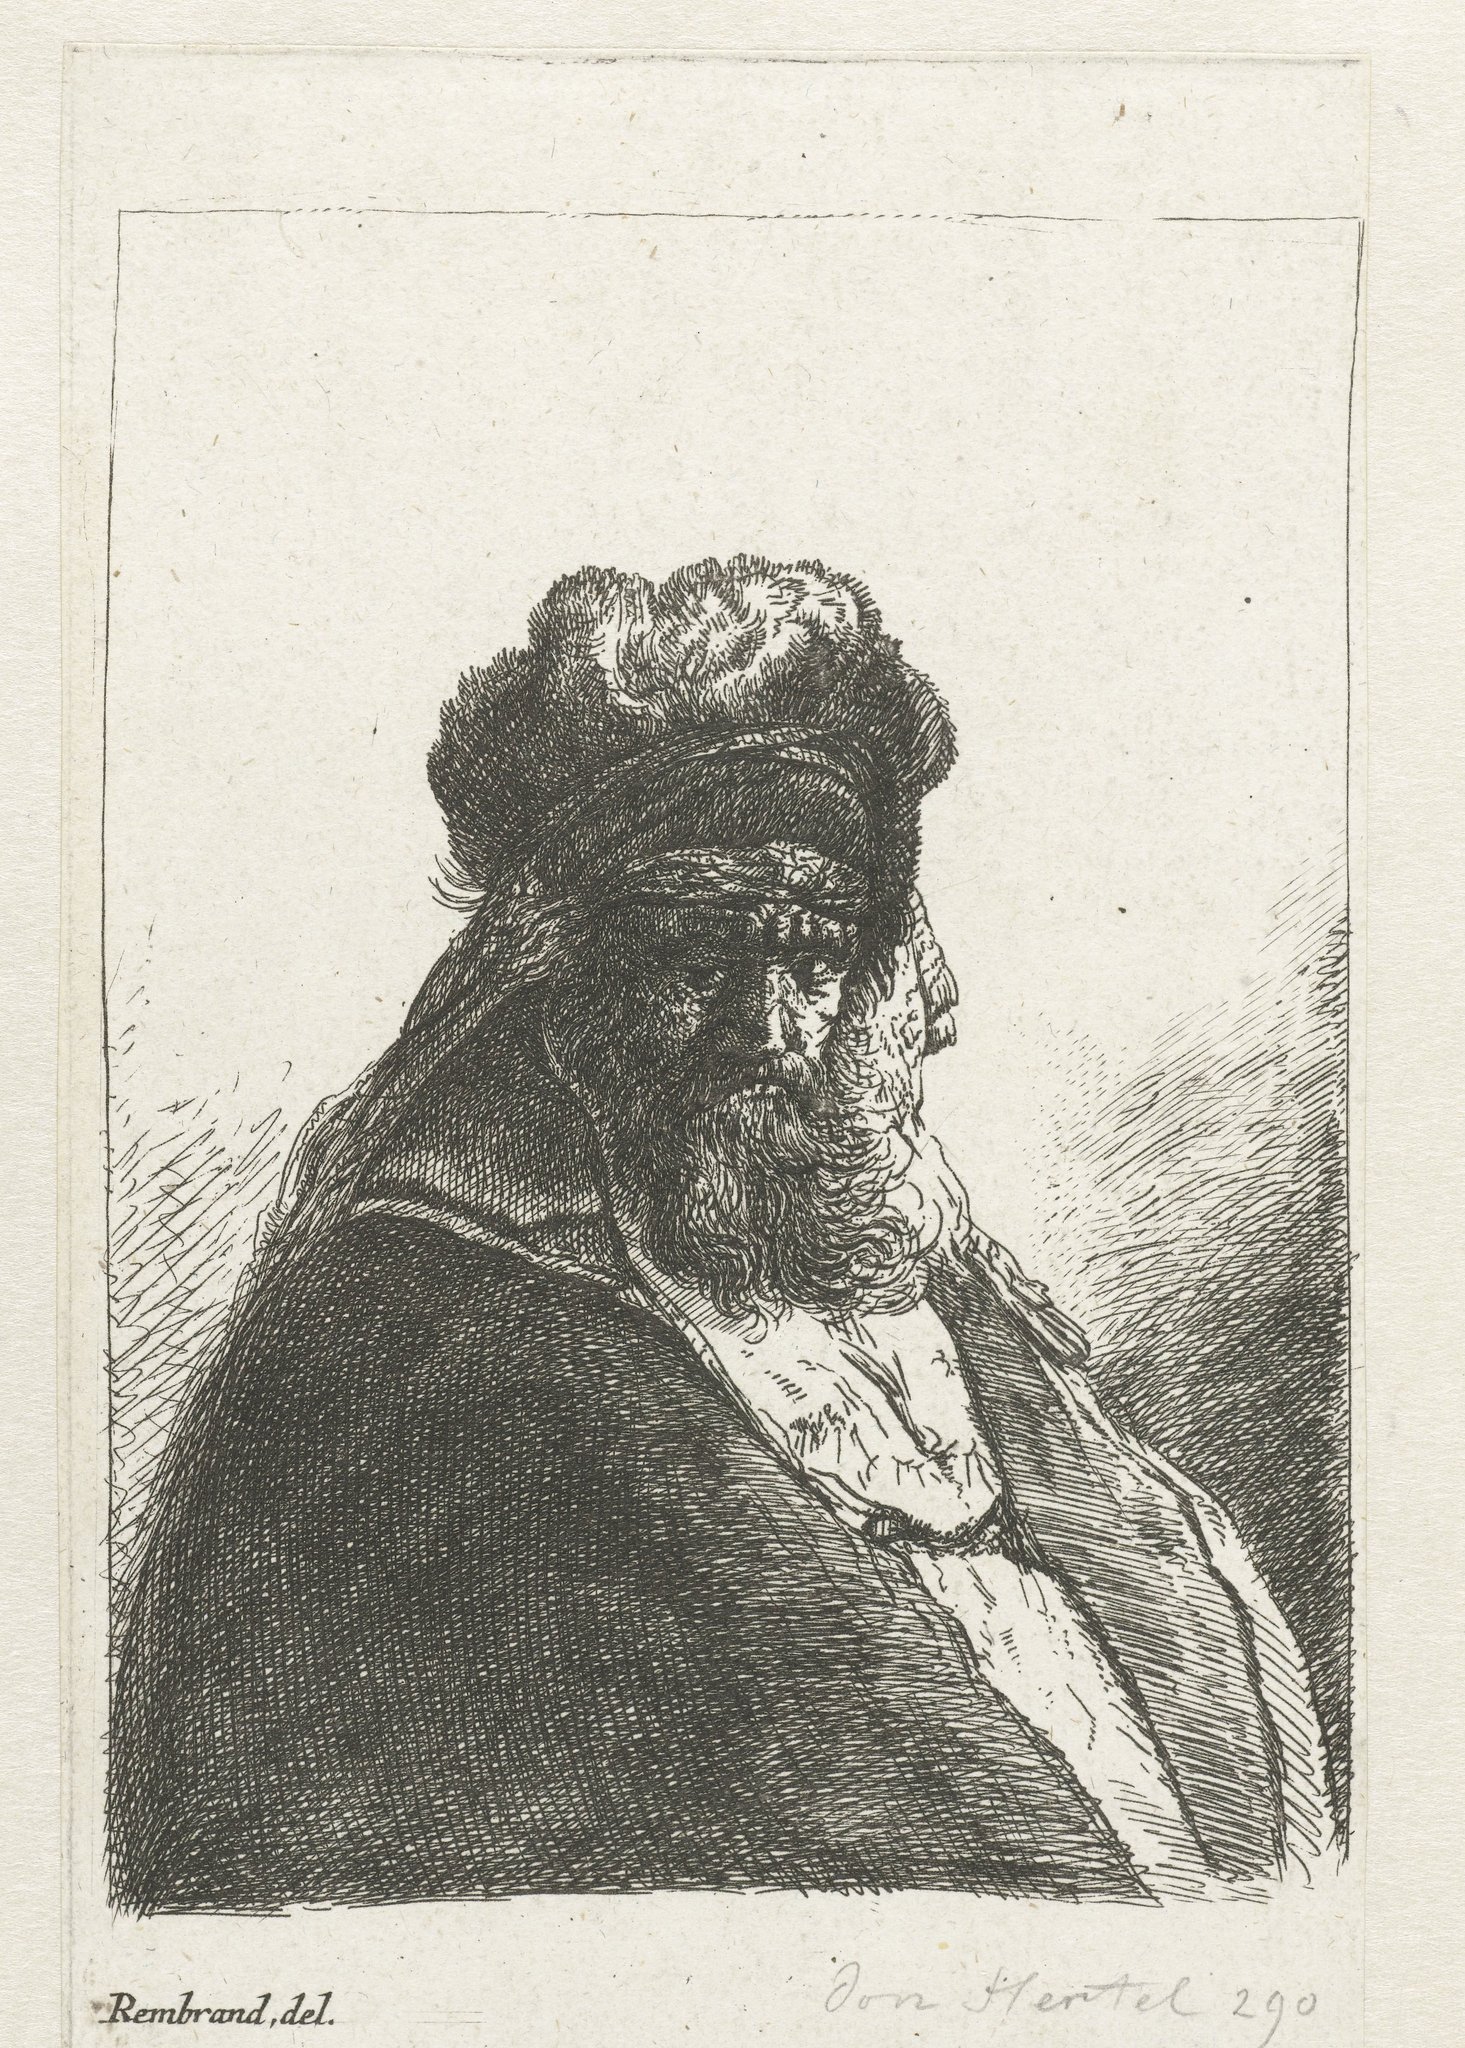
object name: print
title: Bearded old man in a high fur cap, with eyes closed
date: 1761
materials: paper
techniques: etching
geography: augsburg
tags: head-gear (with name), old man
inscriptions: collector's mark: Lugt 240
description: Spiegelbeeldige kopie naar de gelijknamige prent van Rembrandt.